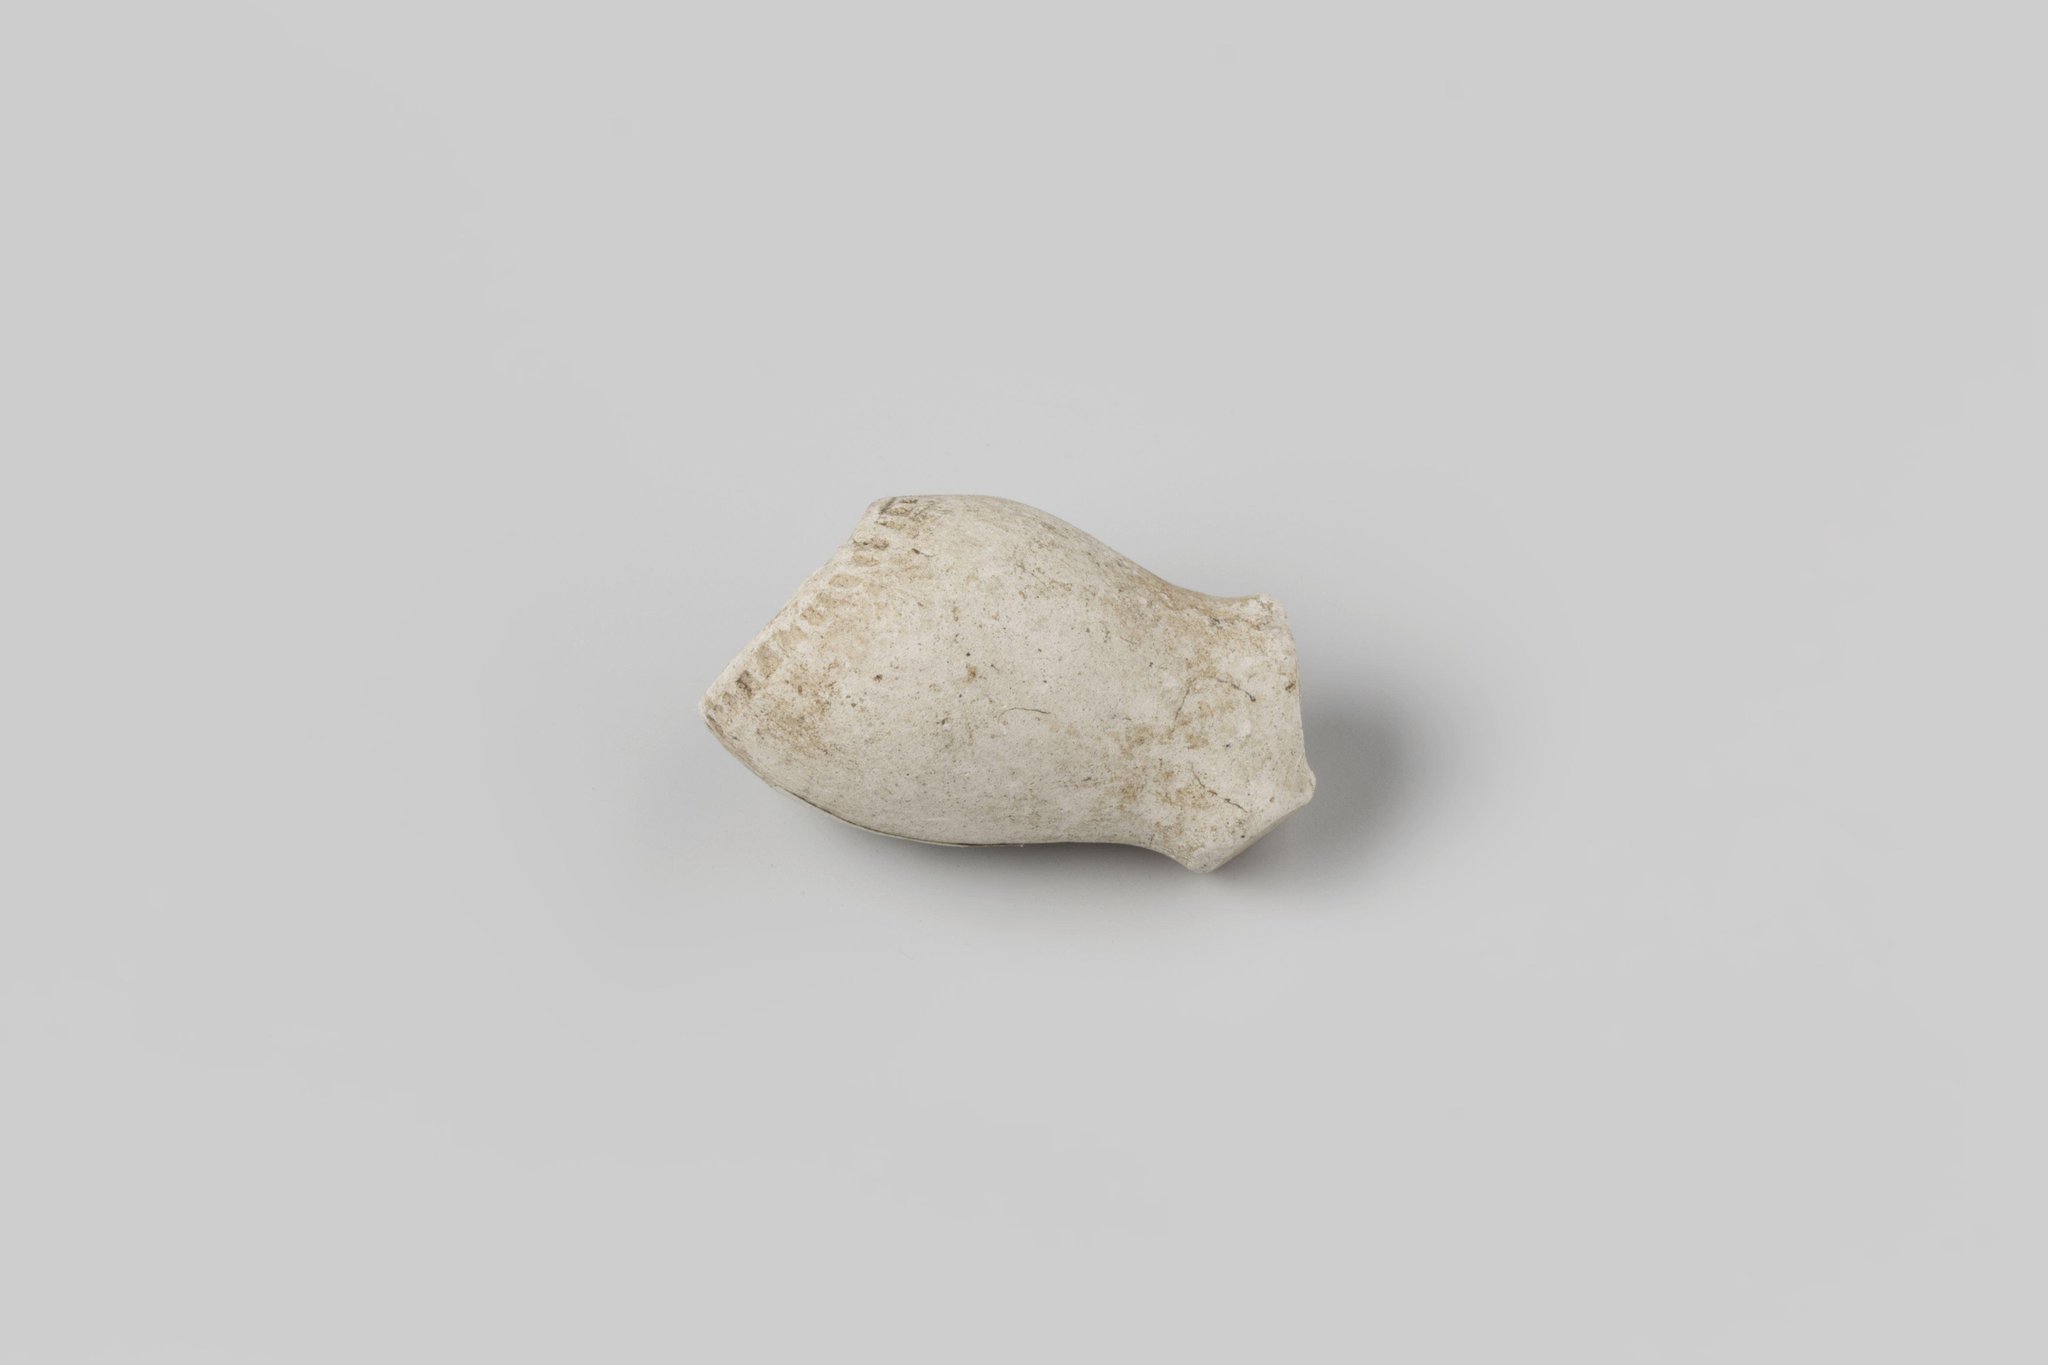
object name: fragment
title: Fragment pijpenkop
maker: Anonymous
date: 1600-1620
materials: clay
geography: netherlands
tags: the hague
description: Fragment pijpenkop. Van de opgravingen op de Hofstede Arentsburg 1827-1831 onder toezicht van Professor Reuvens.